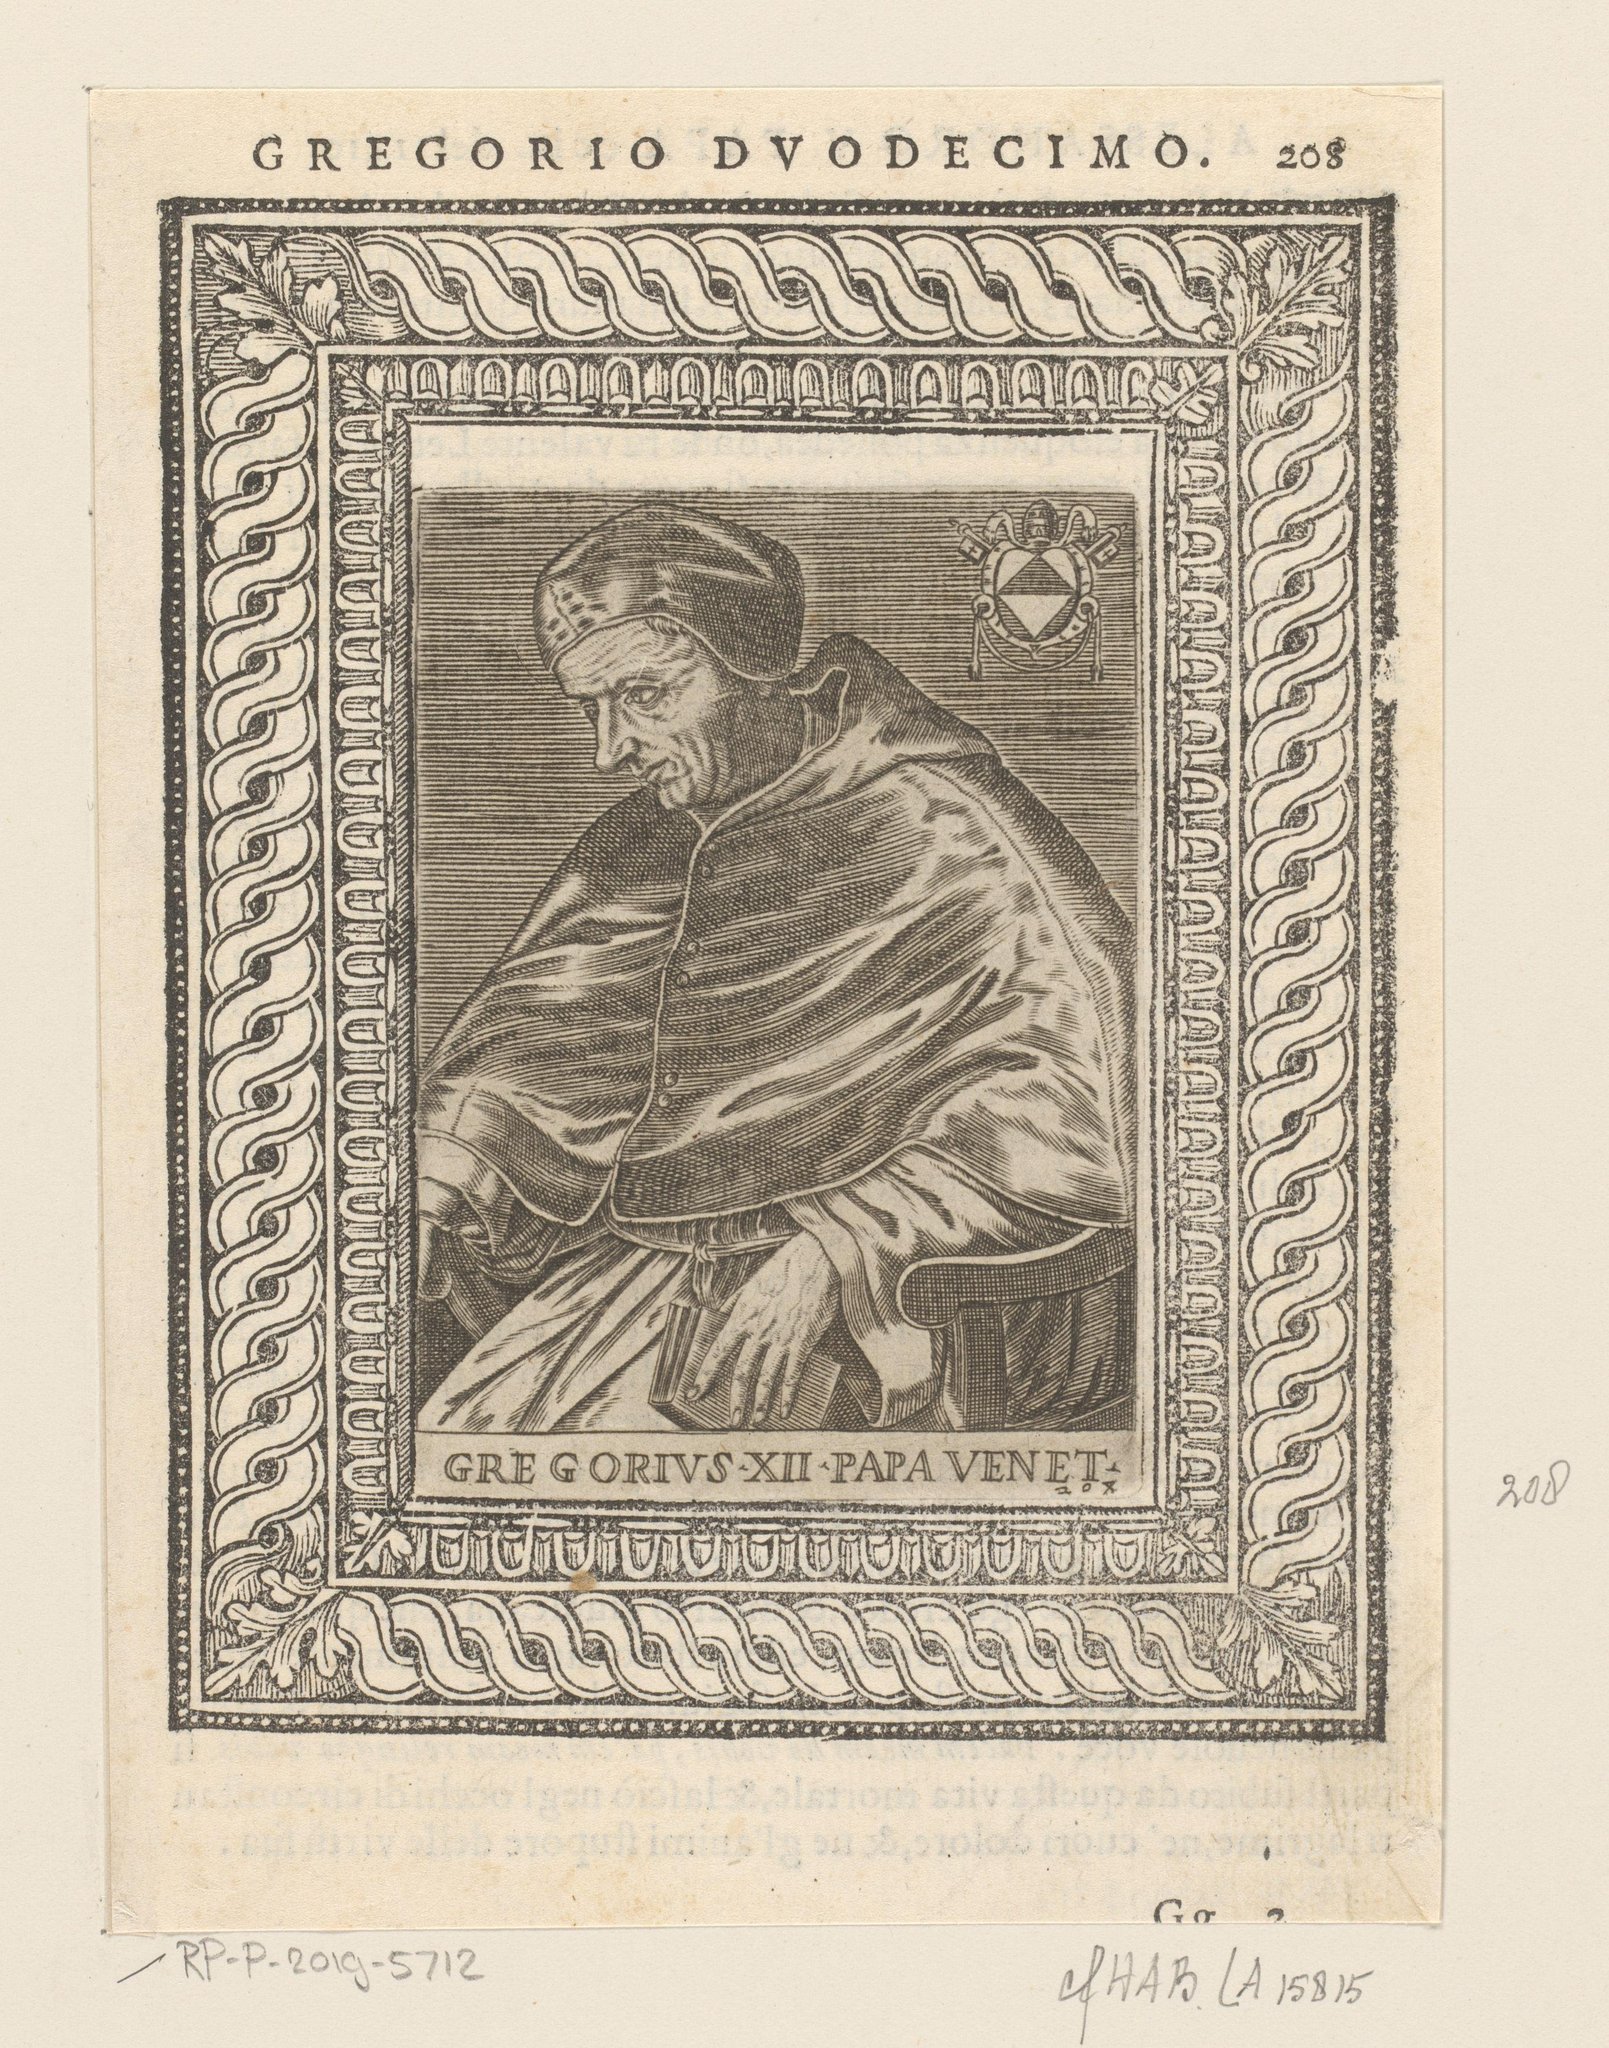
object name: print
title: Gregorius XII Papa Venet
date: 1587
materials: paper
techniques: engraving, letterpress printing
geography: rome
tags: venice, clergyman, historical persons, pope, armorial bearing, heraldry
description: Prent uit: Ciccarelli, Antonio. Le vite de Pontefici di Antonio Ciccarelli (...). Rome: Domenico Basa, 1587. Prent voor het eerst verschenen in: Cavalieri, Giovanni Battista de'. Pontificum romanorum effigies (...). Rome: Domenico Basa en Francesco Zanetti, 1580. Prent ook gebruikt in latere publicaties.